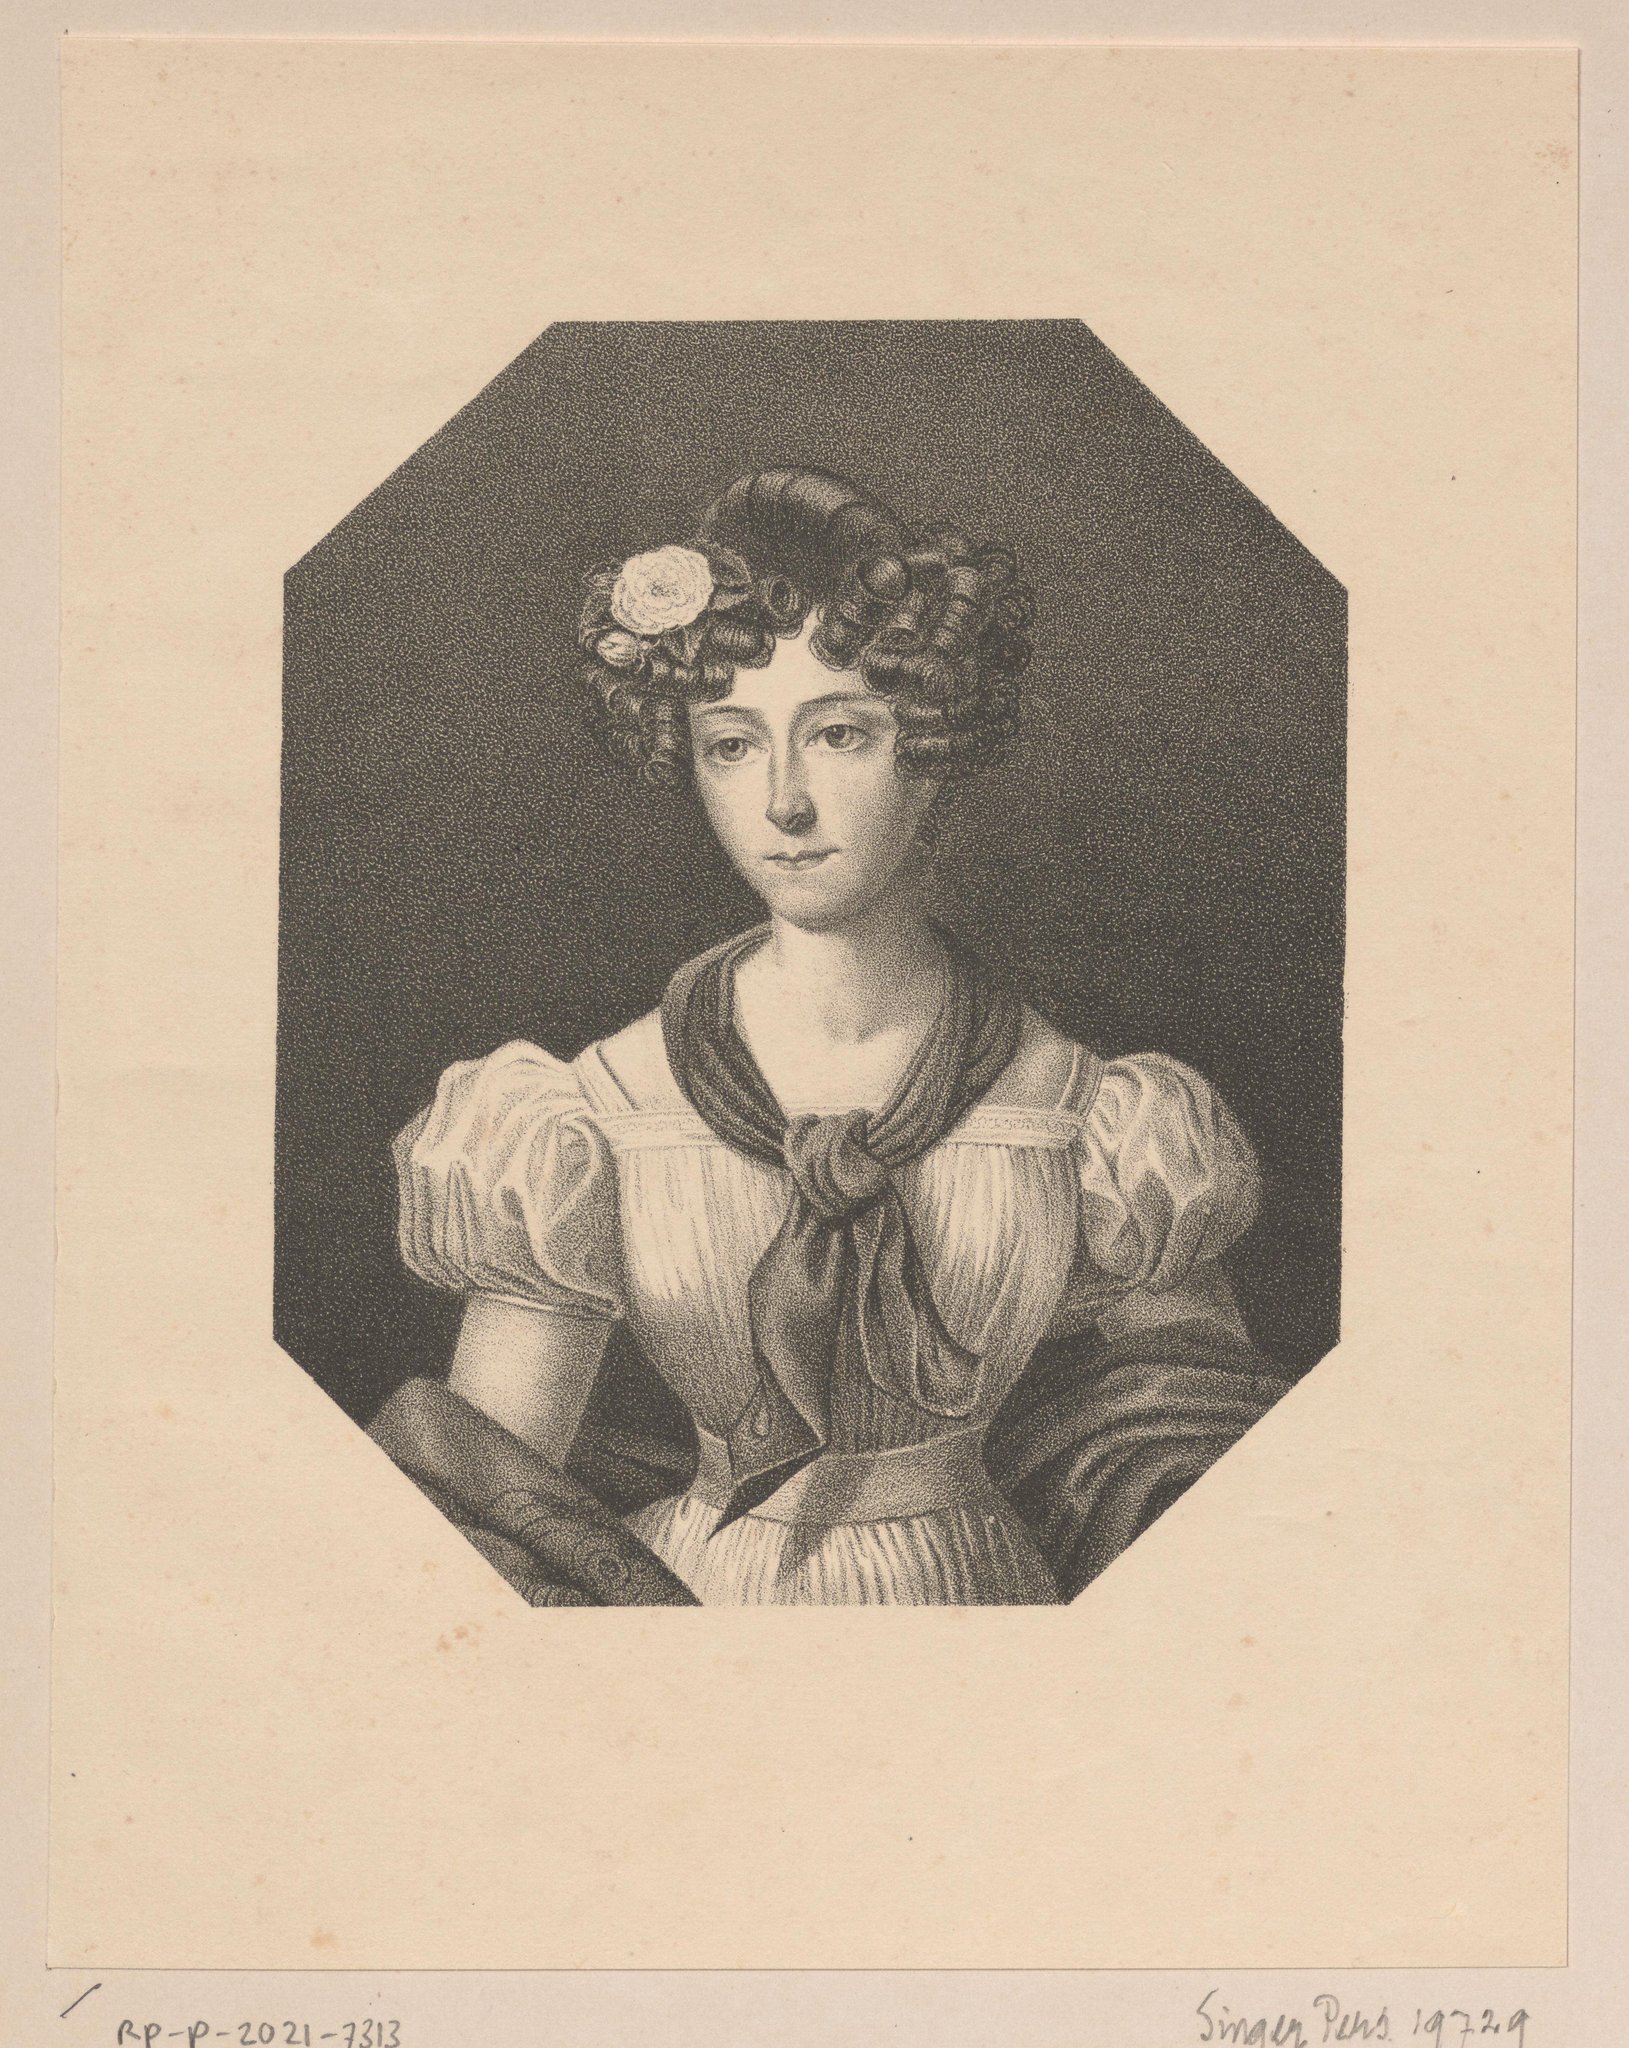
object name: print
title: Portret van Marie van Saksen-Weimar-Eisenach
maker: Anonymous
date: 1827-1850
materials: paper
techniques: lithograph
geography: germany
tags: berlin, historical persons - bb - woman